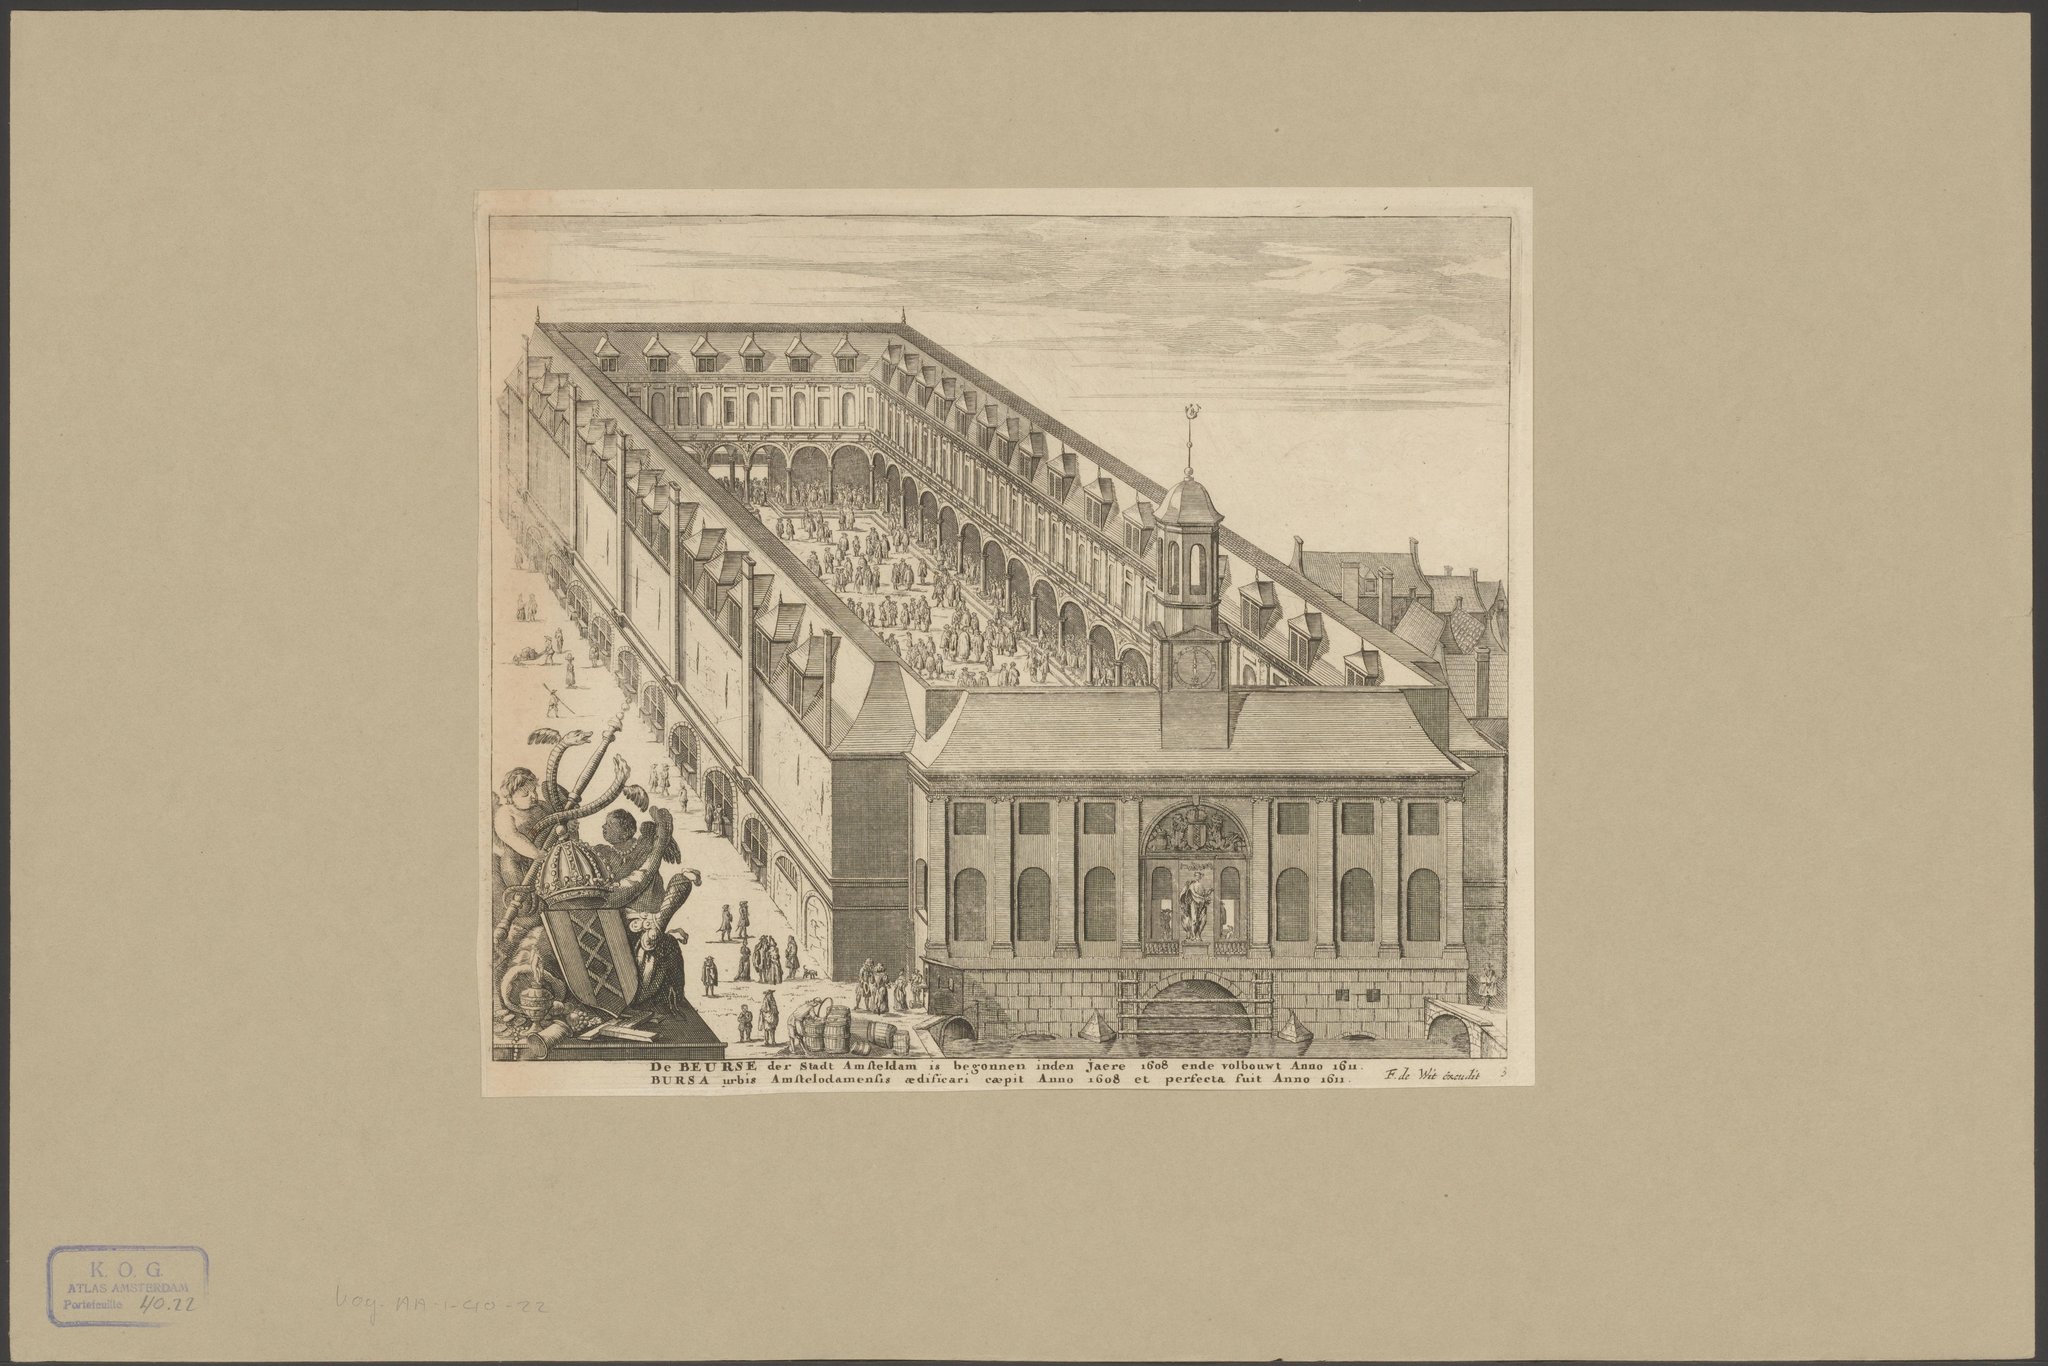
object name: print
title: Vogelvluchtgezicht op de Beurs van Hendrik de Keyser te Amsterdam, na 1668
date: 1701-1726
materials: paper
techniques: engraving, etching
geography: amsterdam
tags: coat of arms (as symbol of the state, etc.) (+ city; municipal), stock exchange, stock-market, courtyard, caduceus (staff with two snakes, attribute of mercury), street (+ city(-scape) with figures, staffage)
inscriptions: collector's mark: Lugt 1641b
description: Prent mogelijk uit: Les Forces de l'Europe, Asie, Afrique et Amerique (...). Amsterdam: Pieter Mortier (I), [1701]. Of uit: Les Forces de l'Europe, Asie, Afrique et Amerique (...). 20 dln. Parijs en Leiden: Nicolas de Fer (?) en Pieter (I) van der Aa, [1726], dl. 13.